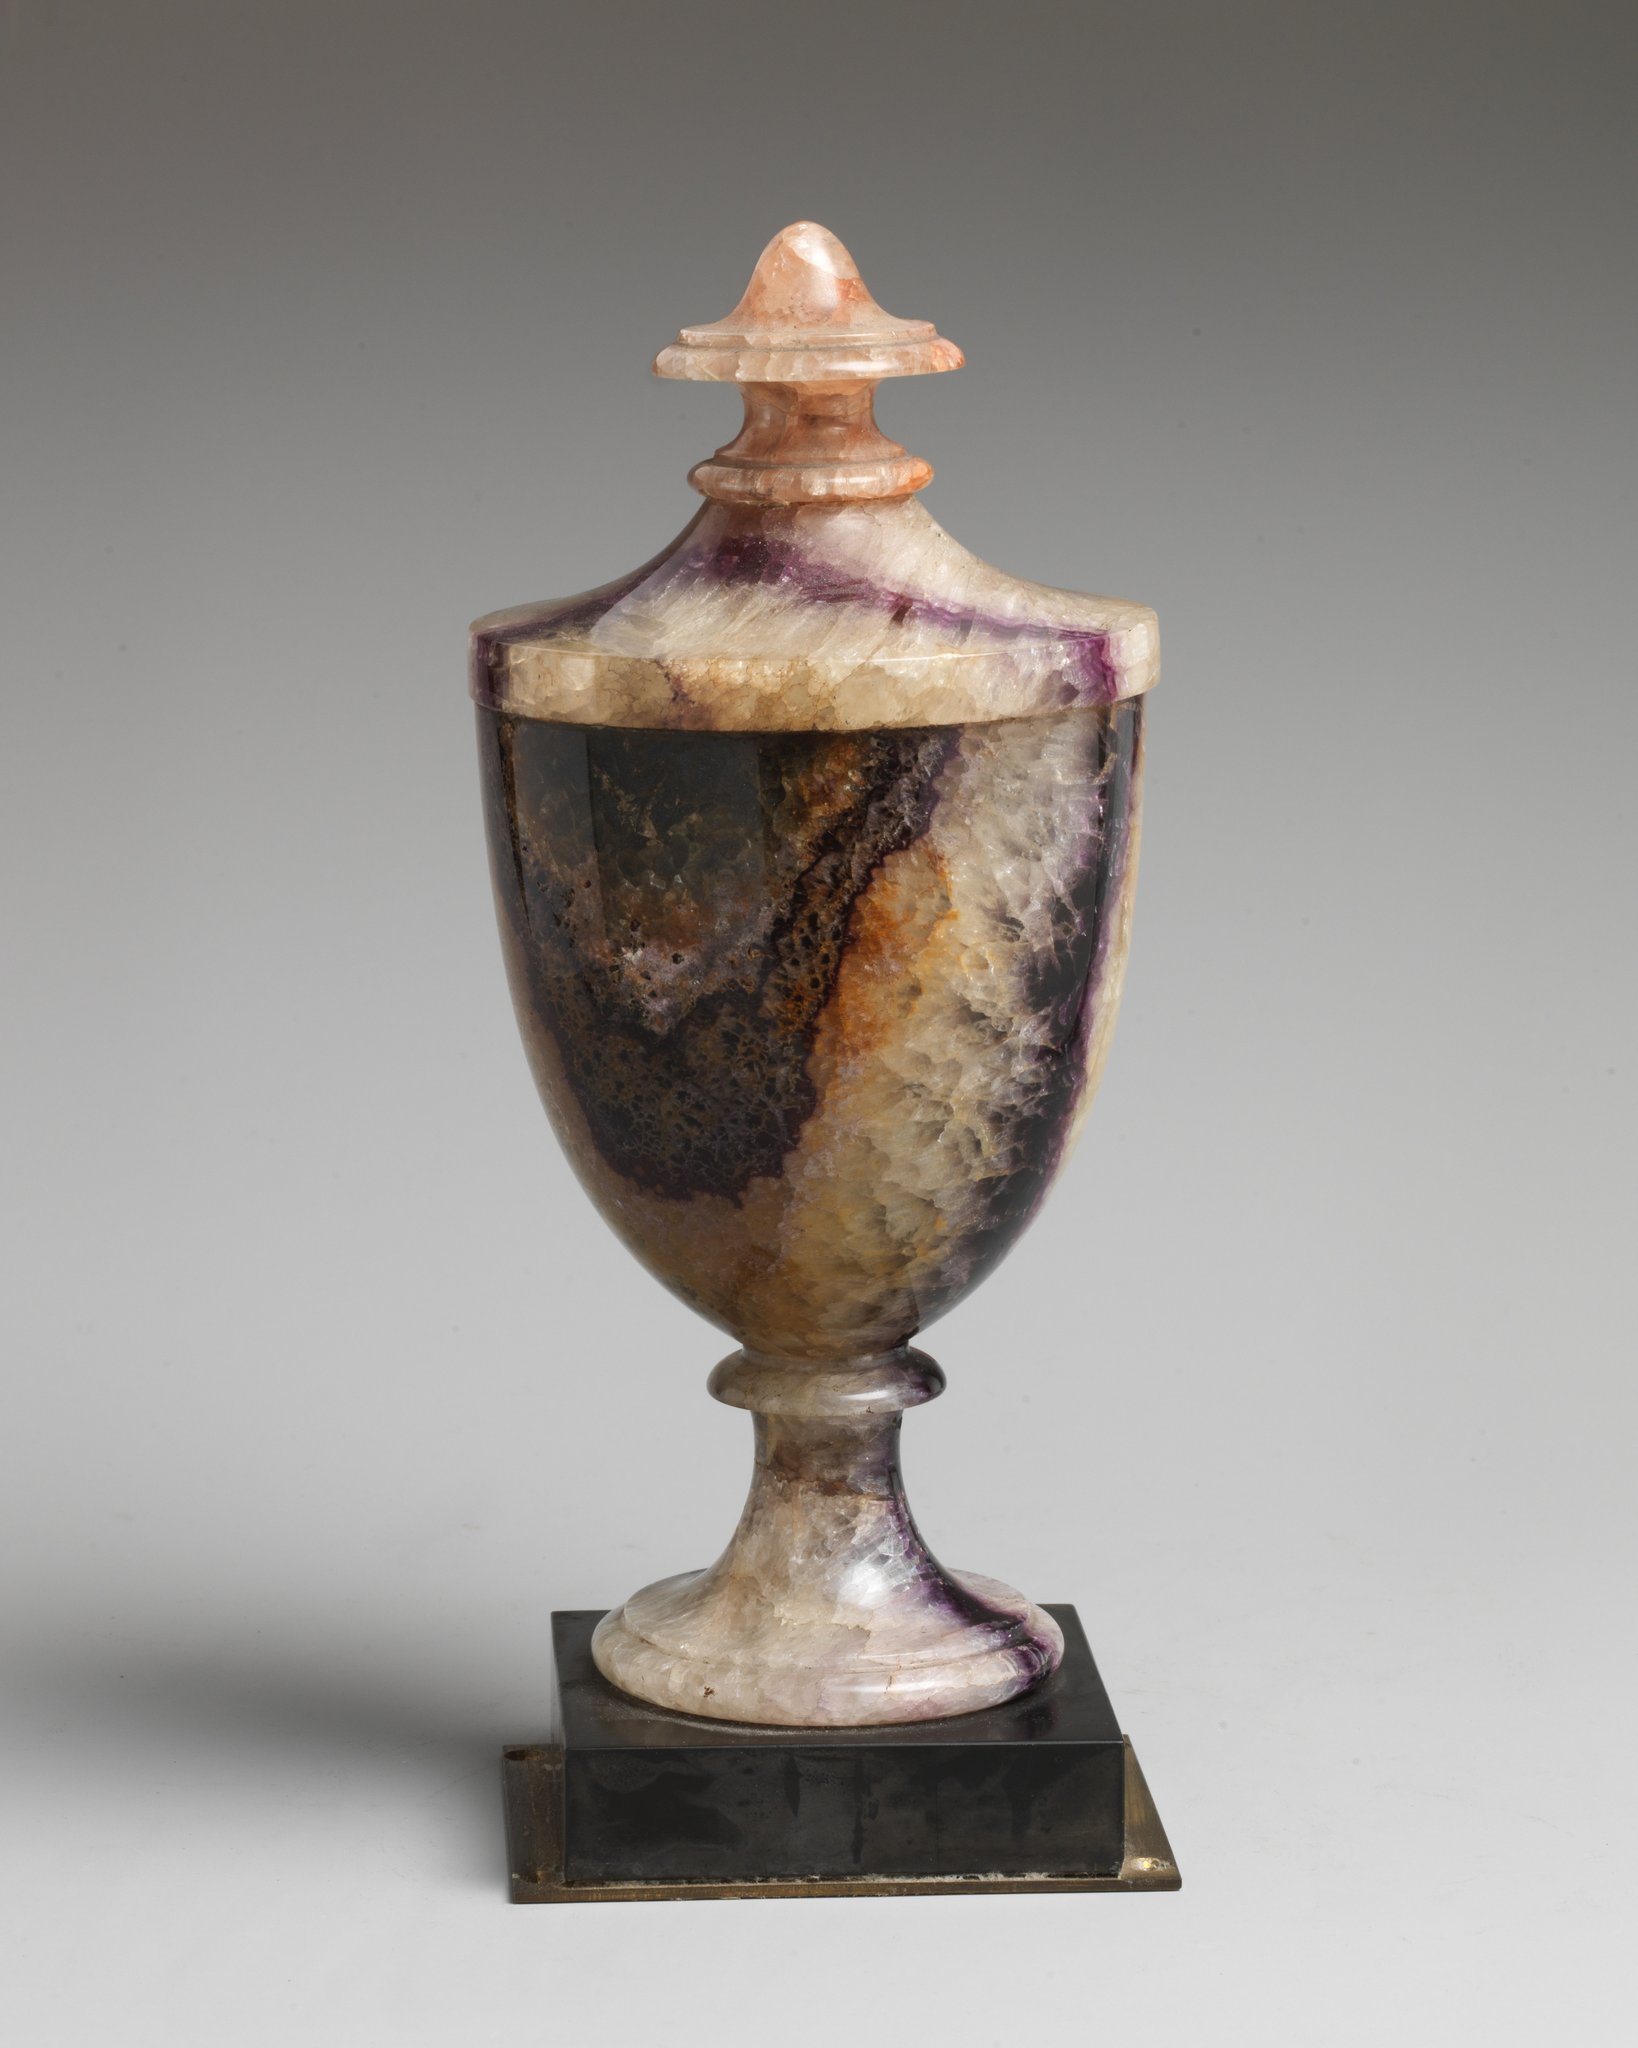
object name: ornament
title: Ornament (one of a pair)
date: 1770-1780